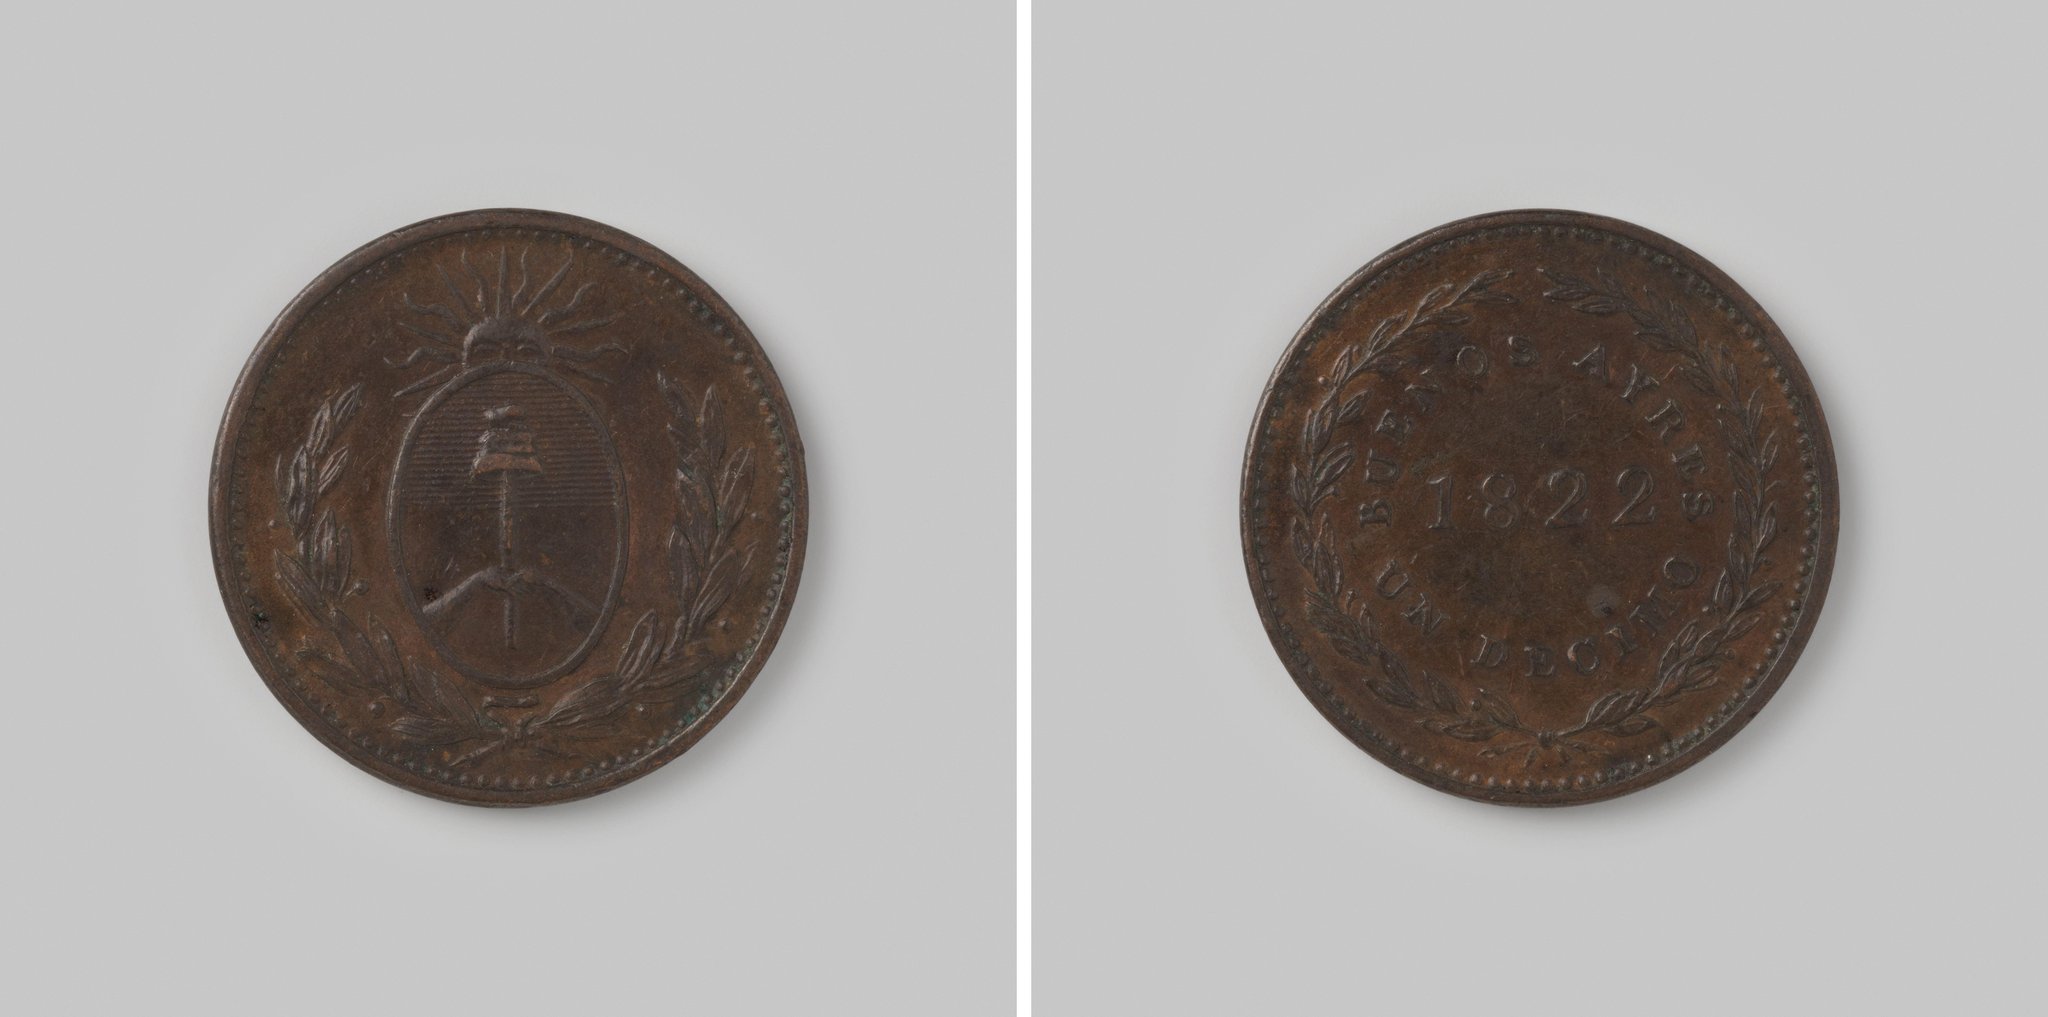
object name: coin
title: Decimo uit Buenos Aires, Argentinië, 1822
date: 1822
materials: copper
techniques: striking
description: Koperen munt. Voorzijde: tussen twee samengebonden takken onder een stralende zon een ovaal schild, waarin door twee handen vastgehouden staande pijl met op de punt een vrijheidshoed. Keerzijde: tussen twee samengebonden takken jaartal, waaromheen plaats- aanduiding: Buenos Ayres en waarde-aanduiding: un decimo. Gladde rand.